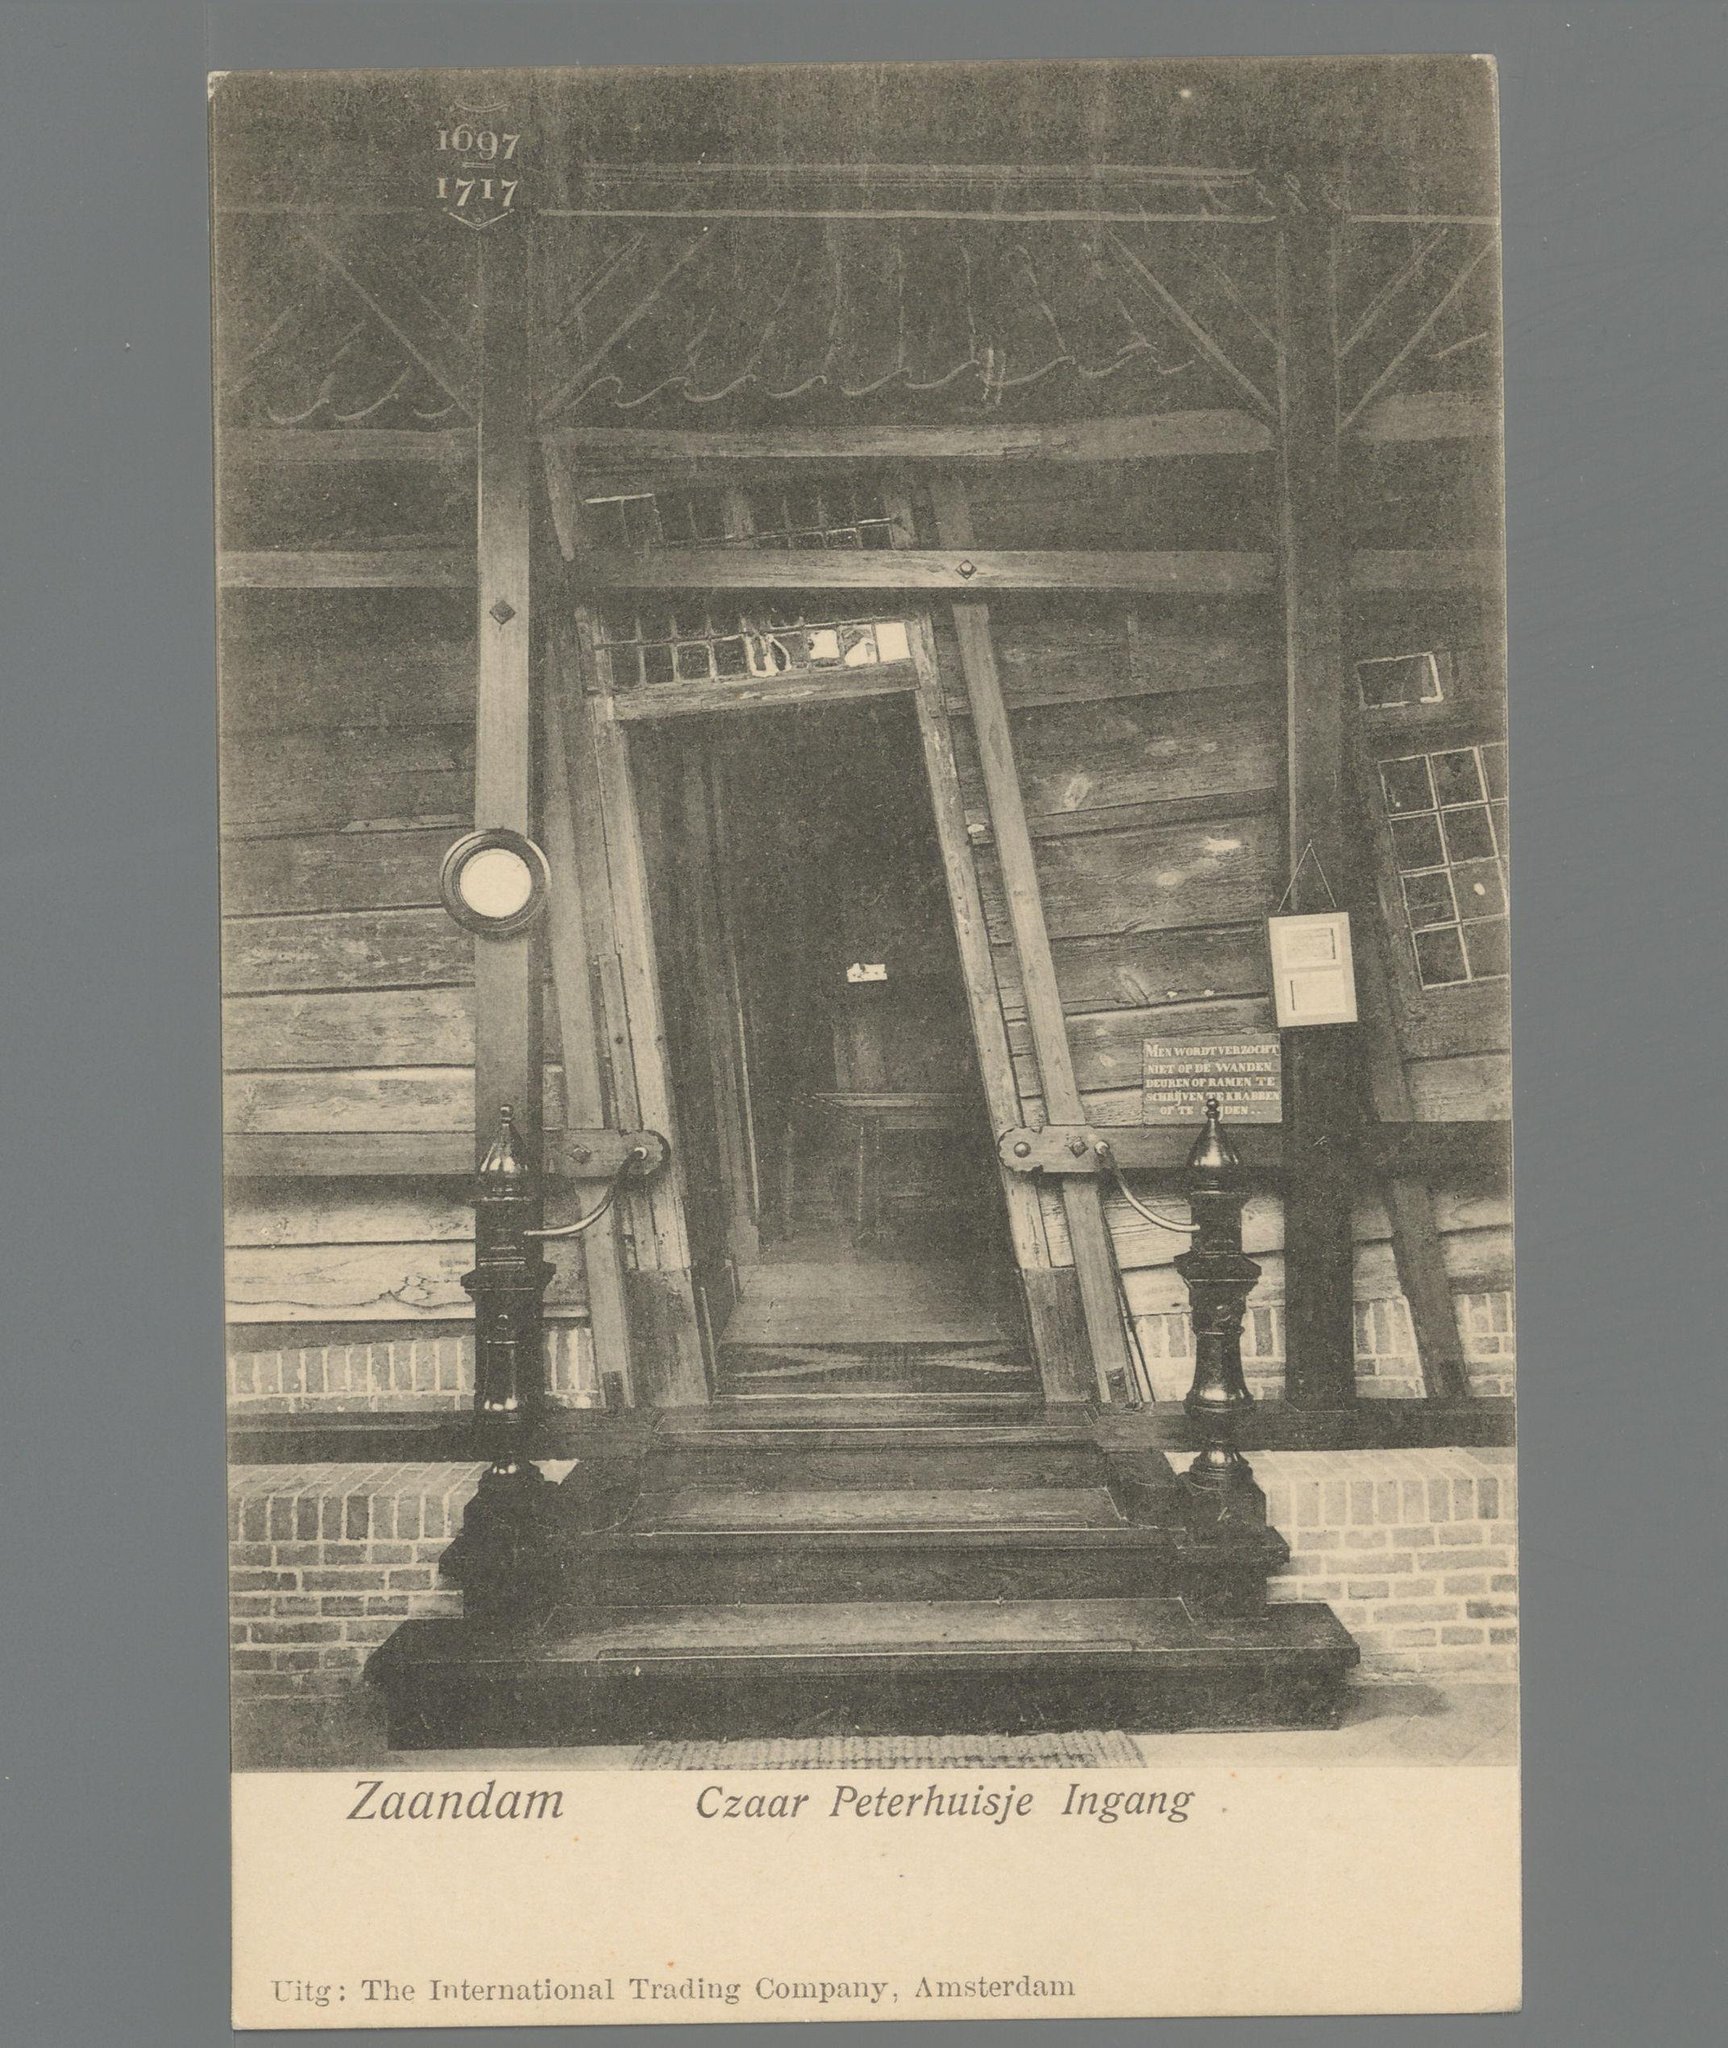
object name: ansichtkaart, prentbriefkaart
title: Zaandam. Czaar Peterhuisje ingang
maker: Anonymous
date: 1897-1905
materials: cardboard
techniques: photograph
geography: amsterdam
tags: gate, entrance, permanent exhibition, museum